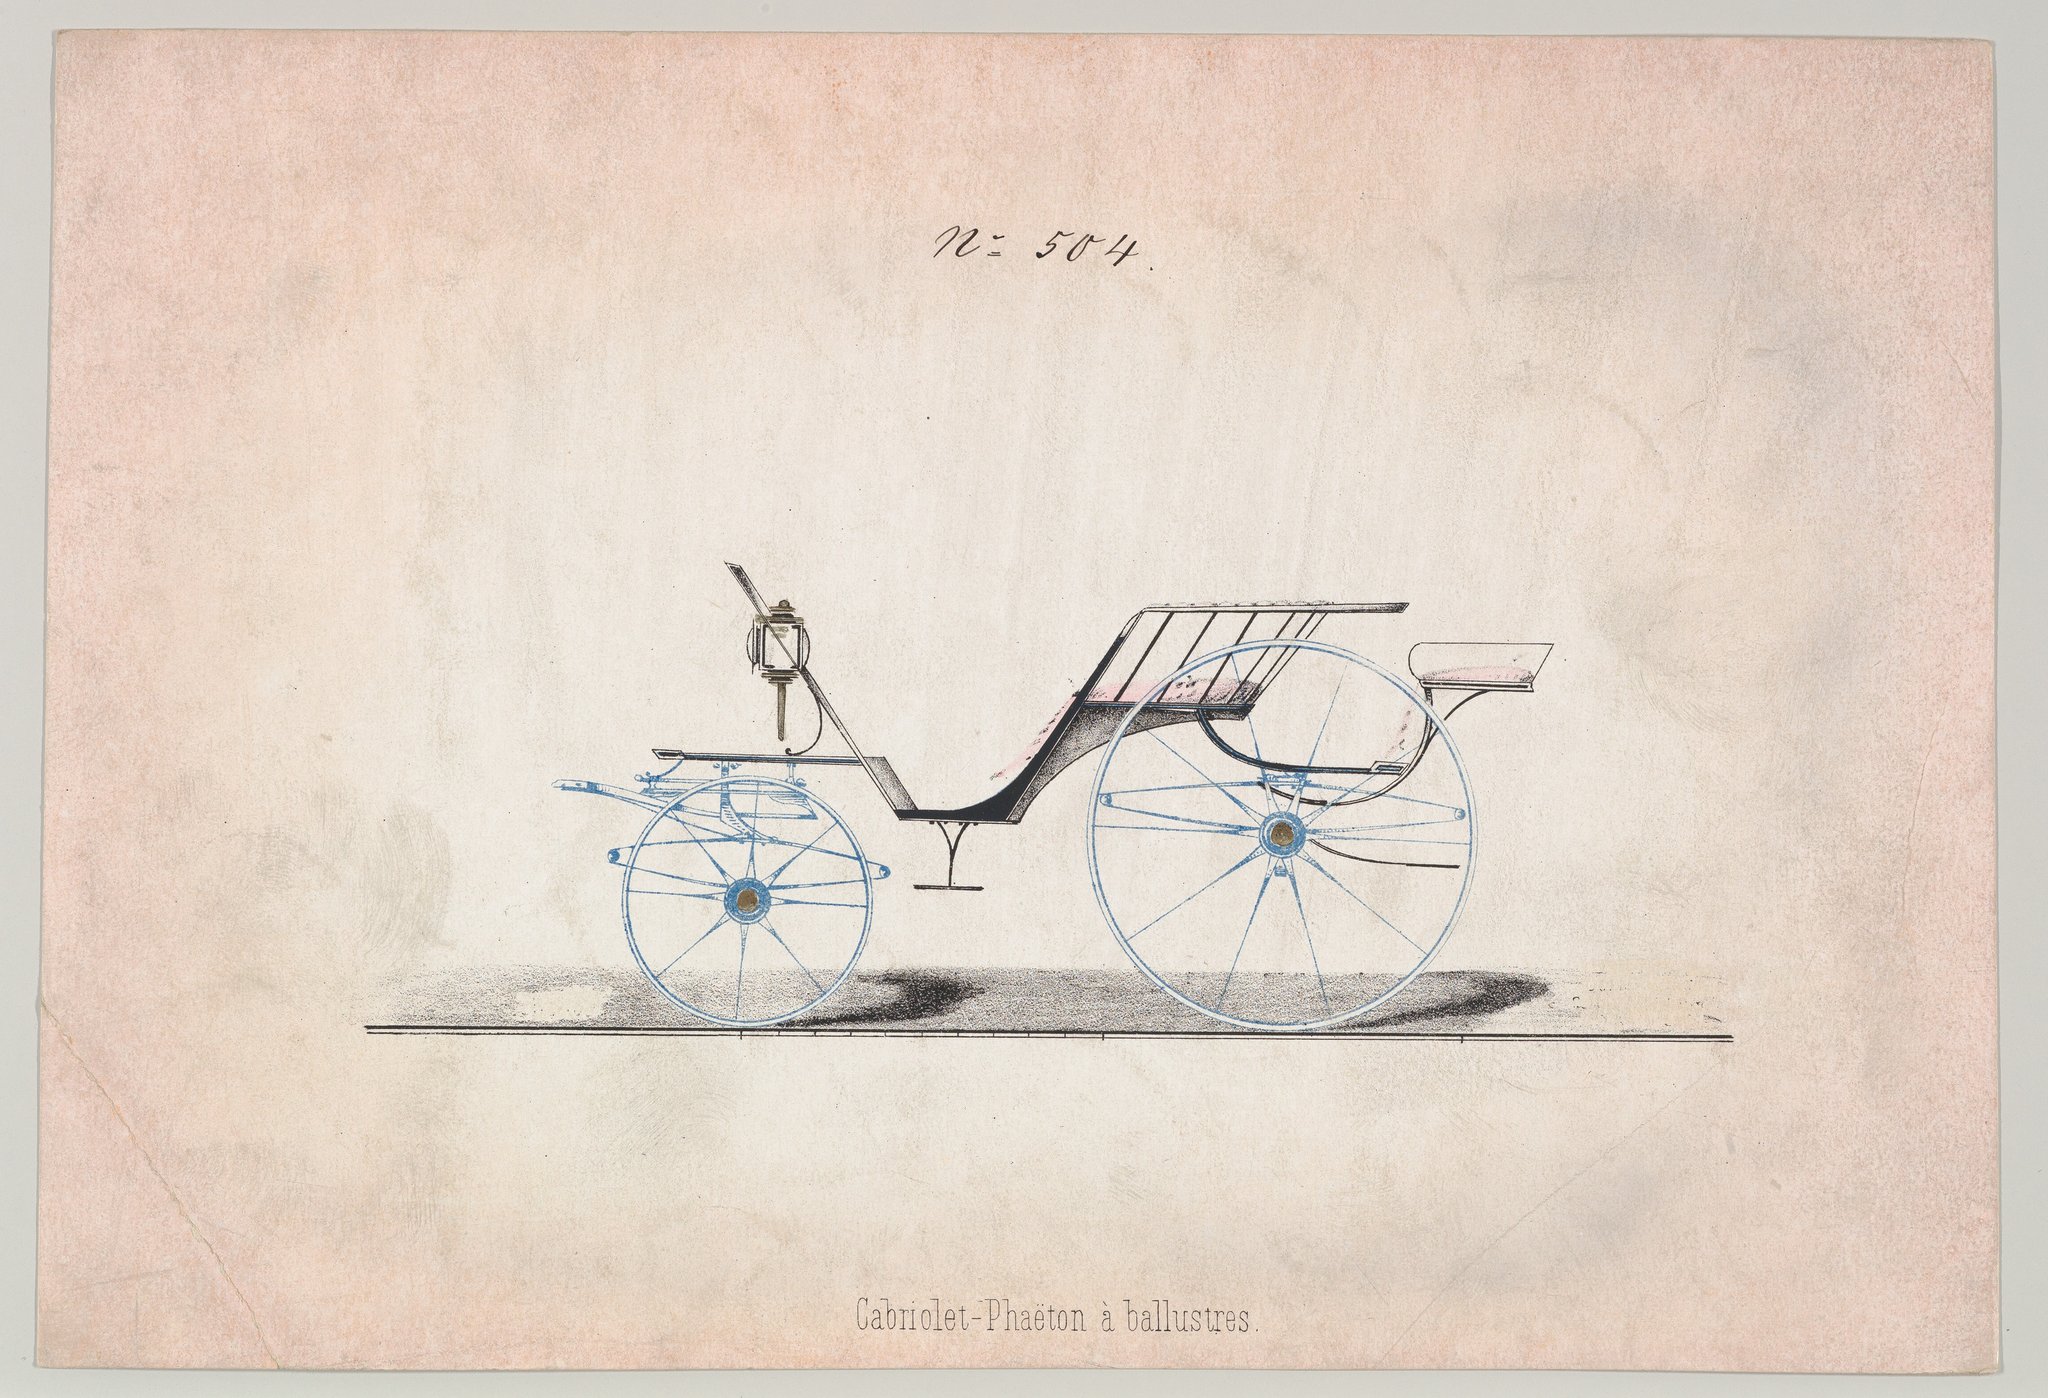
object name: drawing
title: Phaeton #504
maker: brewster & co.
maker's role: manufacturer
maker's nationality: american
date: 1865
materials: graphite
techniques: hand coloring, lithograph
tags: carriages